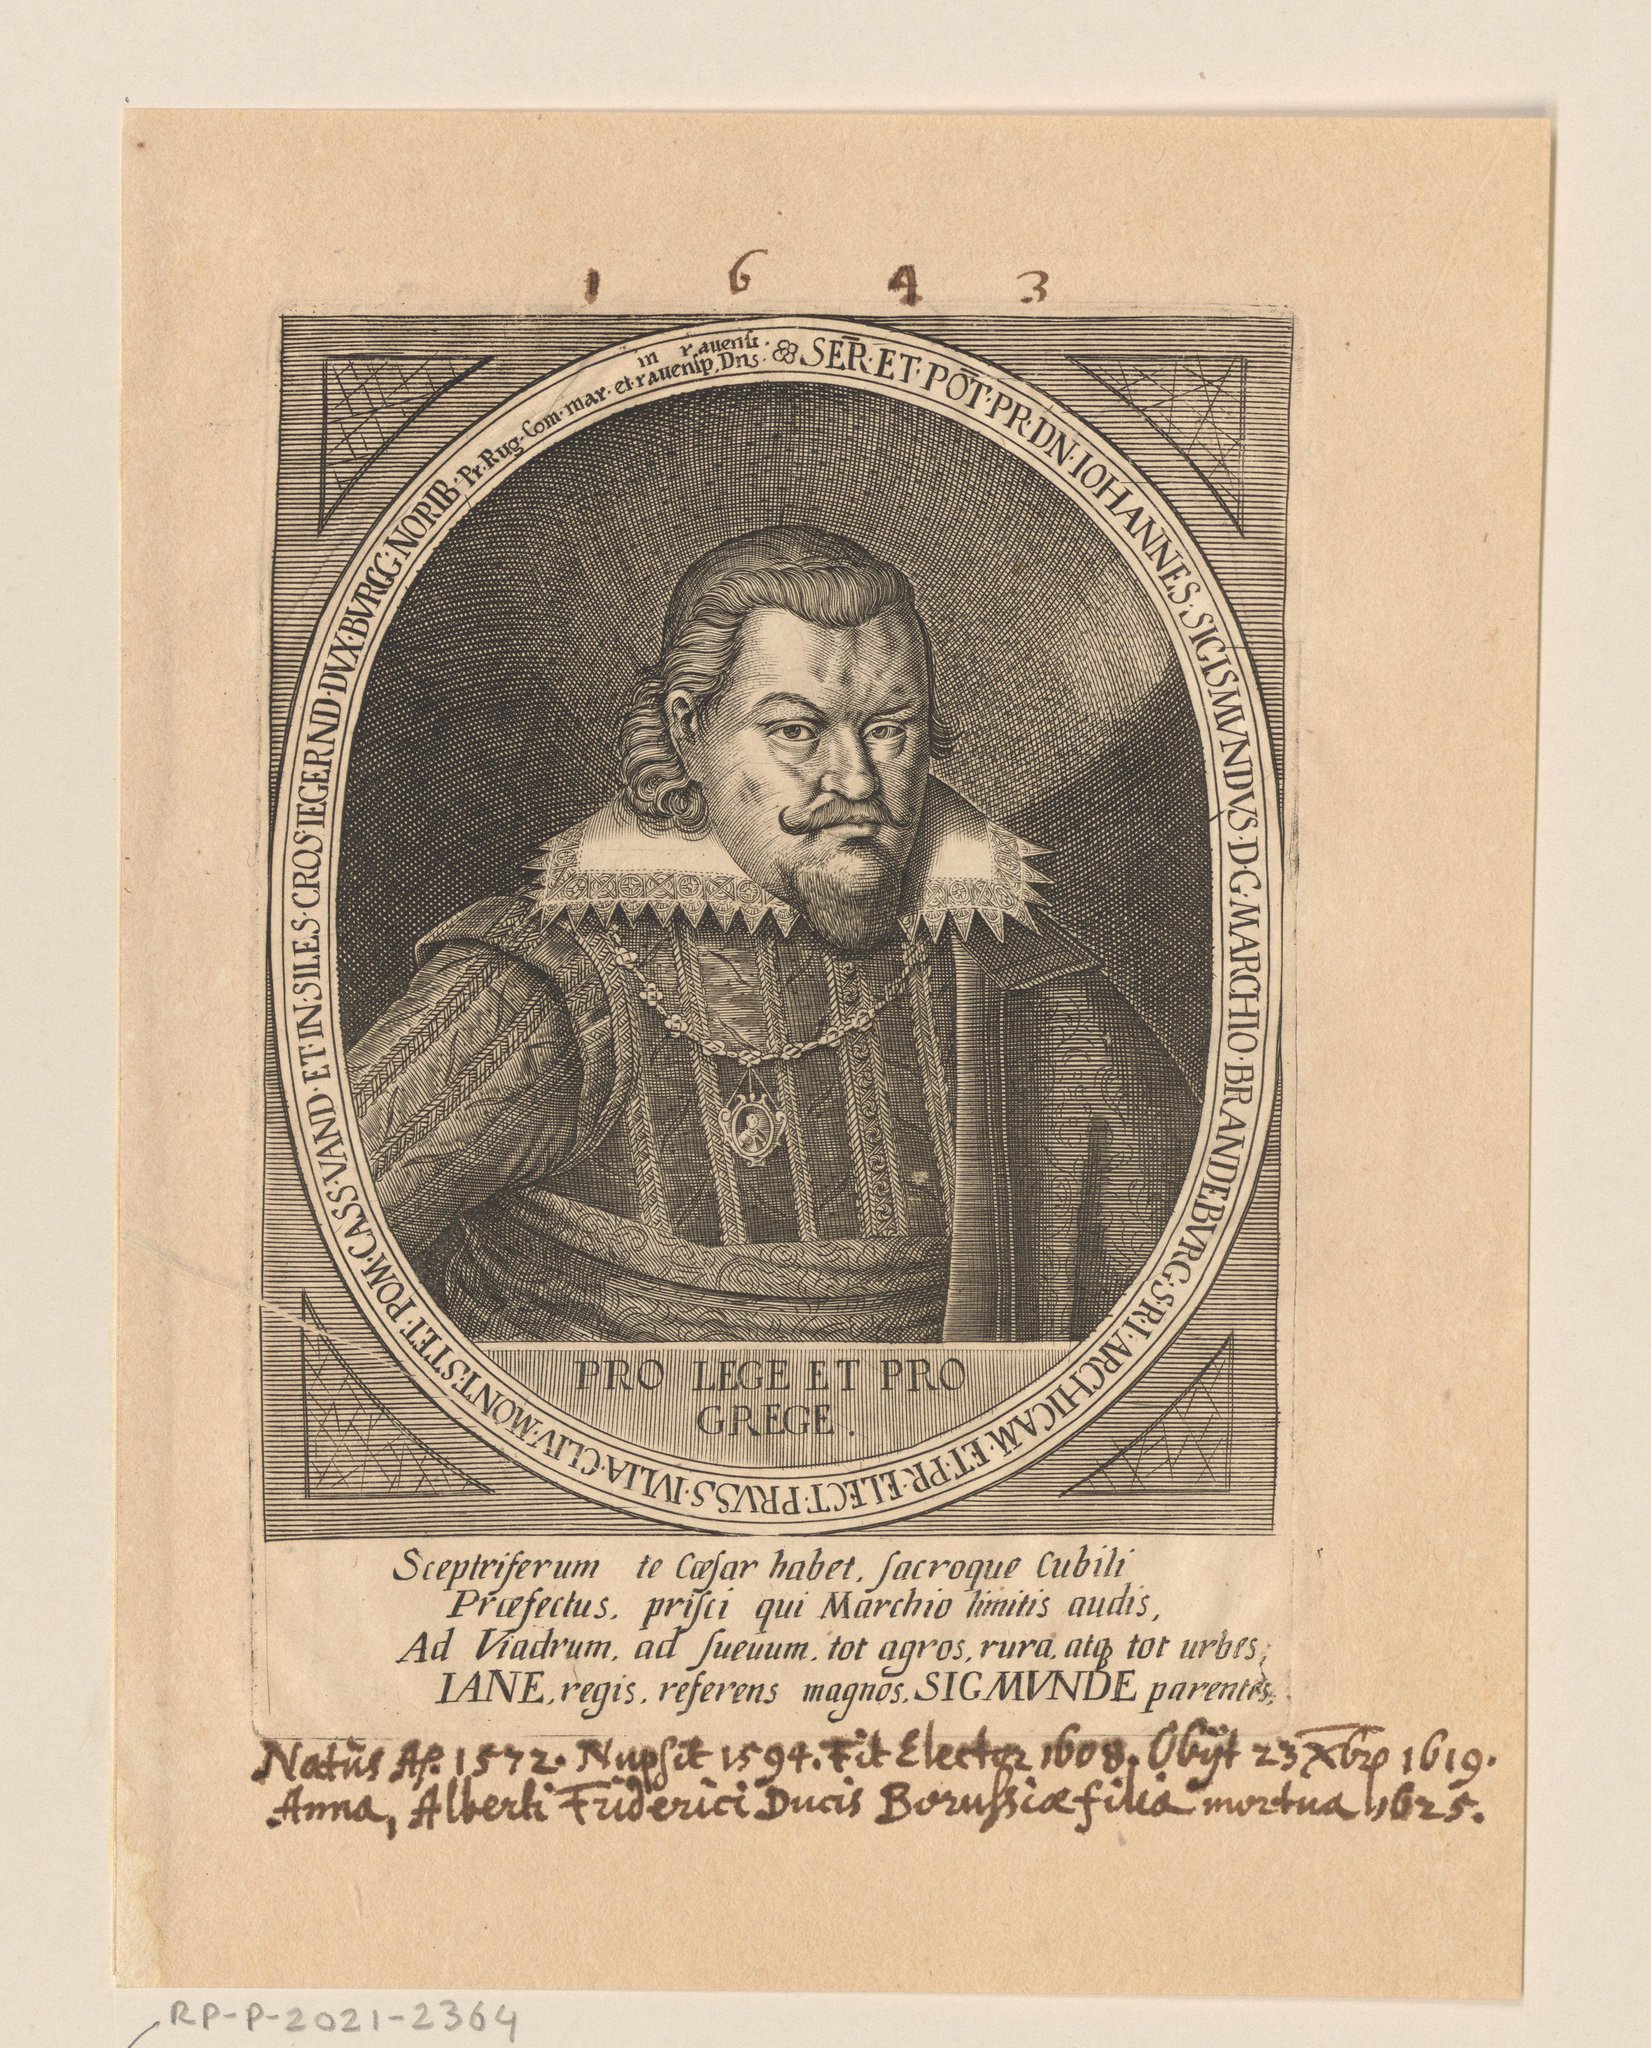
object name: print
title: Portret van Johan Sigismund, keurvorst van Brandenburg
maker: Anonymous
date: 1608-1699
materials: paper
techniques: engraving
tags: historical persons, ruler, sovereign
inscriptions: inscription: ‘1643’, inscription: ‘Natus an. 1572 nupsit 1594 (...)’